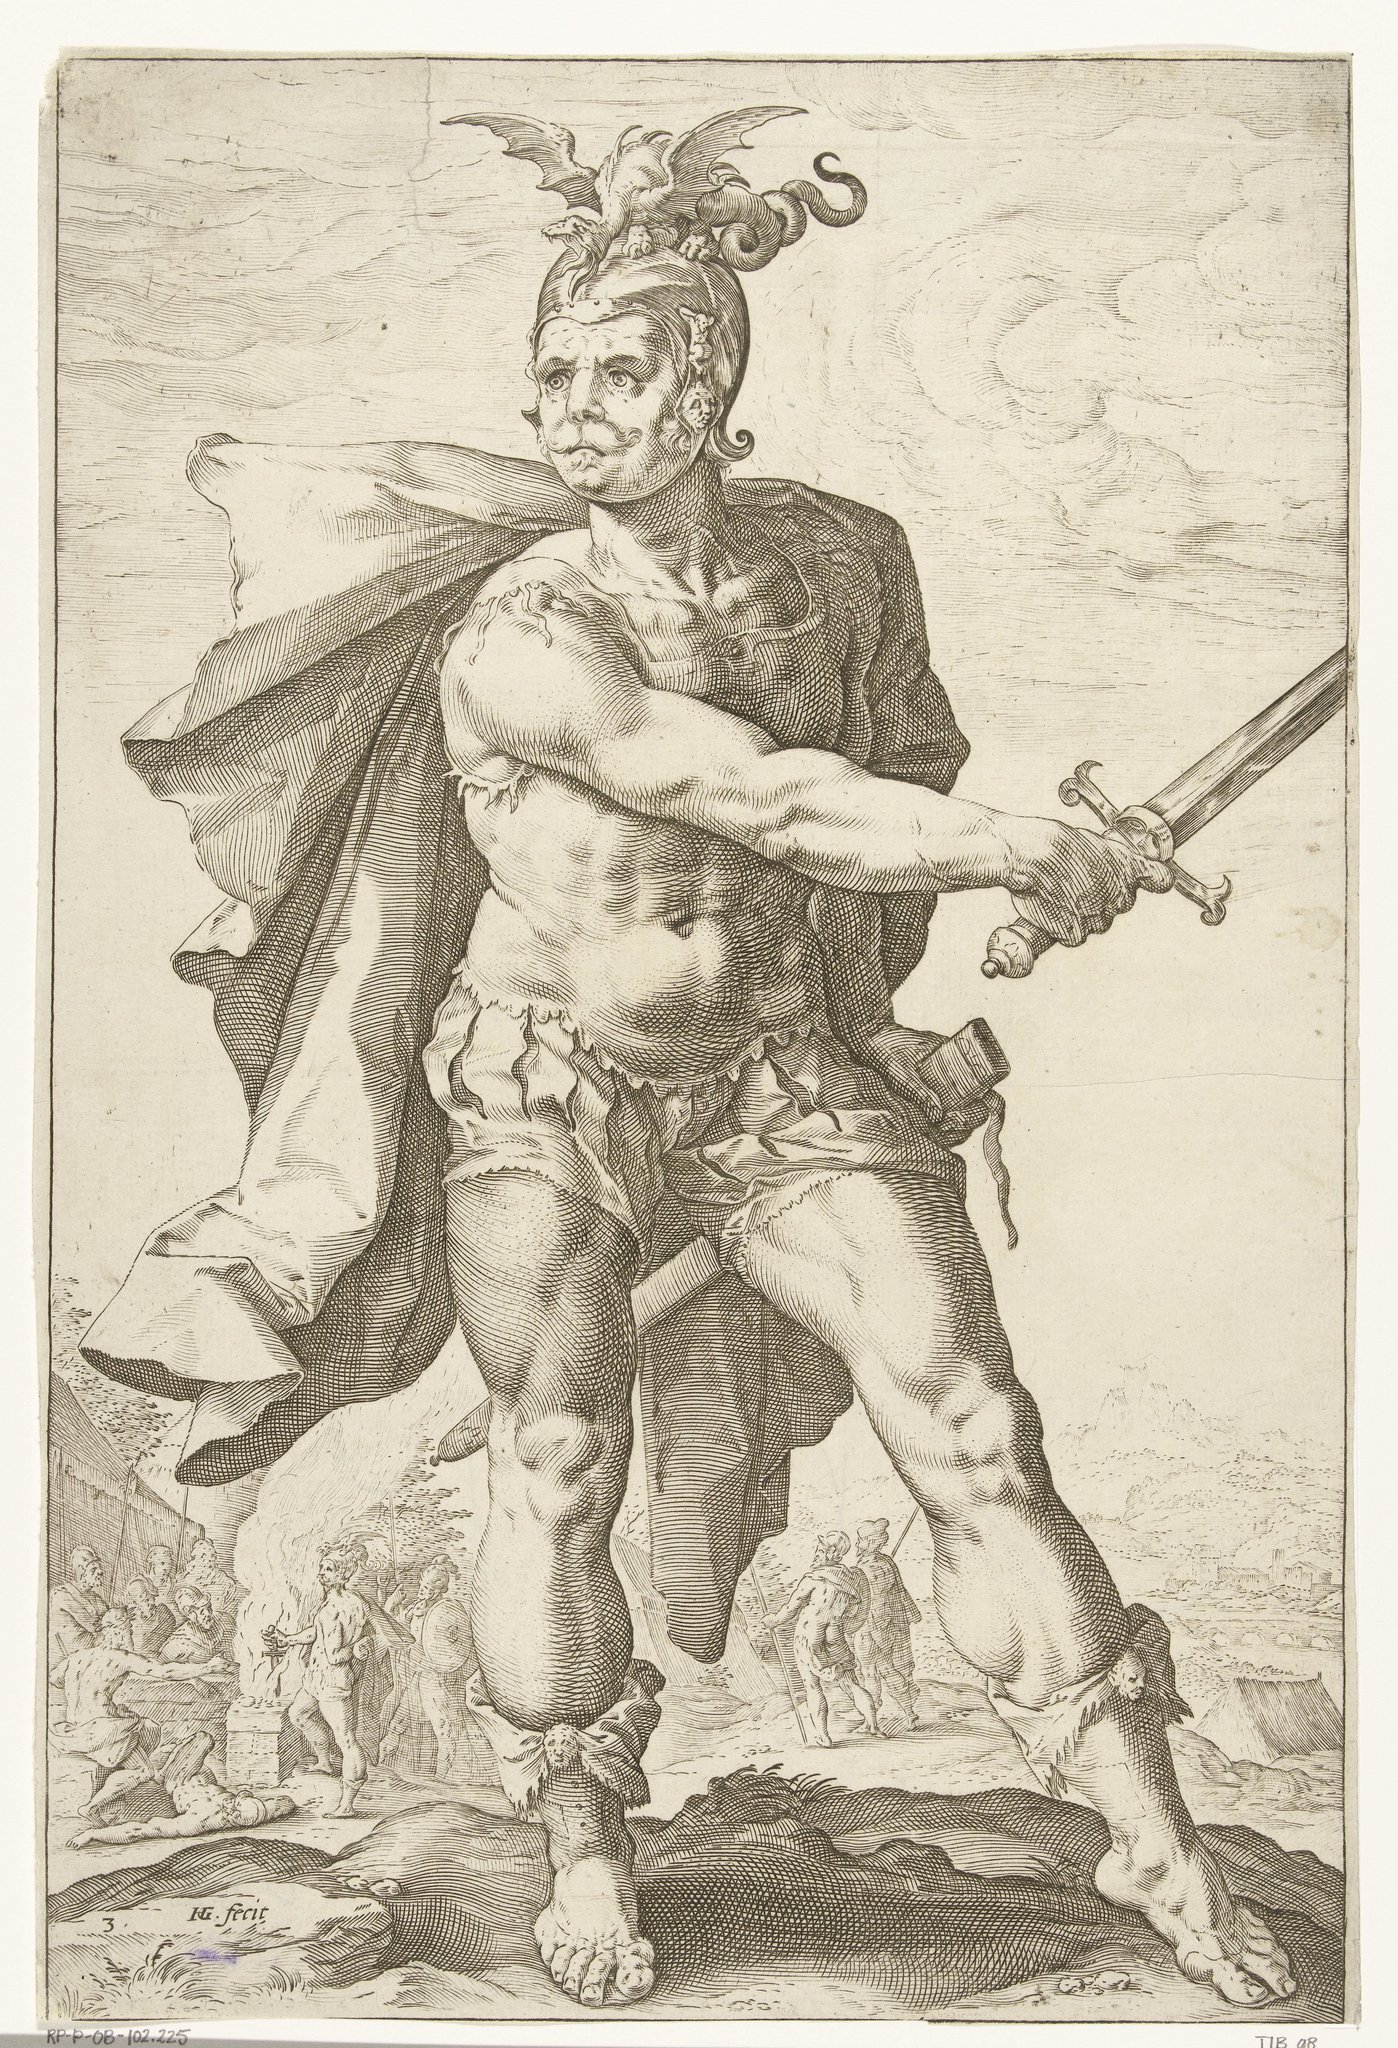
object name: print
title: De Romeinse helden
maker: hendrick goltzius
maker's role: draughtsman, painter, print maker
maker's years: 1558-1617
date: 1586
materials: paper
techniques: engraving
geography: haarlem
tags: gaius mucius scaevola before porsena: he thrusts his right hand into the flames (the body of the king's secretary who erroneously had been killed instead of porsena may be seen lying on the ground)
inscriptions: collector's mark: Lugt 2228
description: De held Gaius Mucius Scaevola ten voeten uit, een zwaard in de rechterhand, de schede in de linkerhand. Op de achtergrond is te zien hoe hij zijn rechterhand voor koning Porsenna onverschrokken in het vuur steekt. Onder de voorstelling twee maal twee versregels in Latijn.